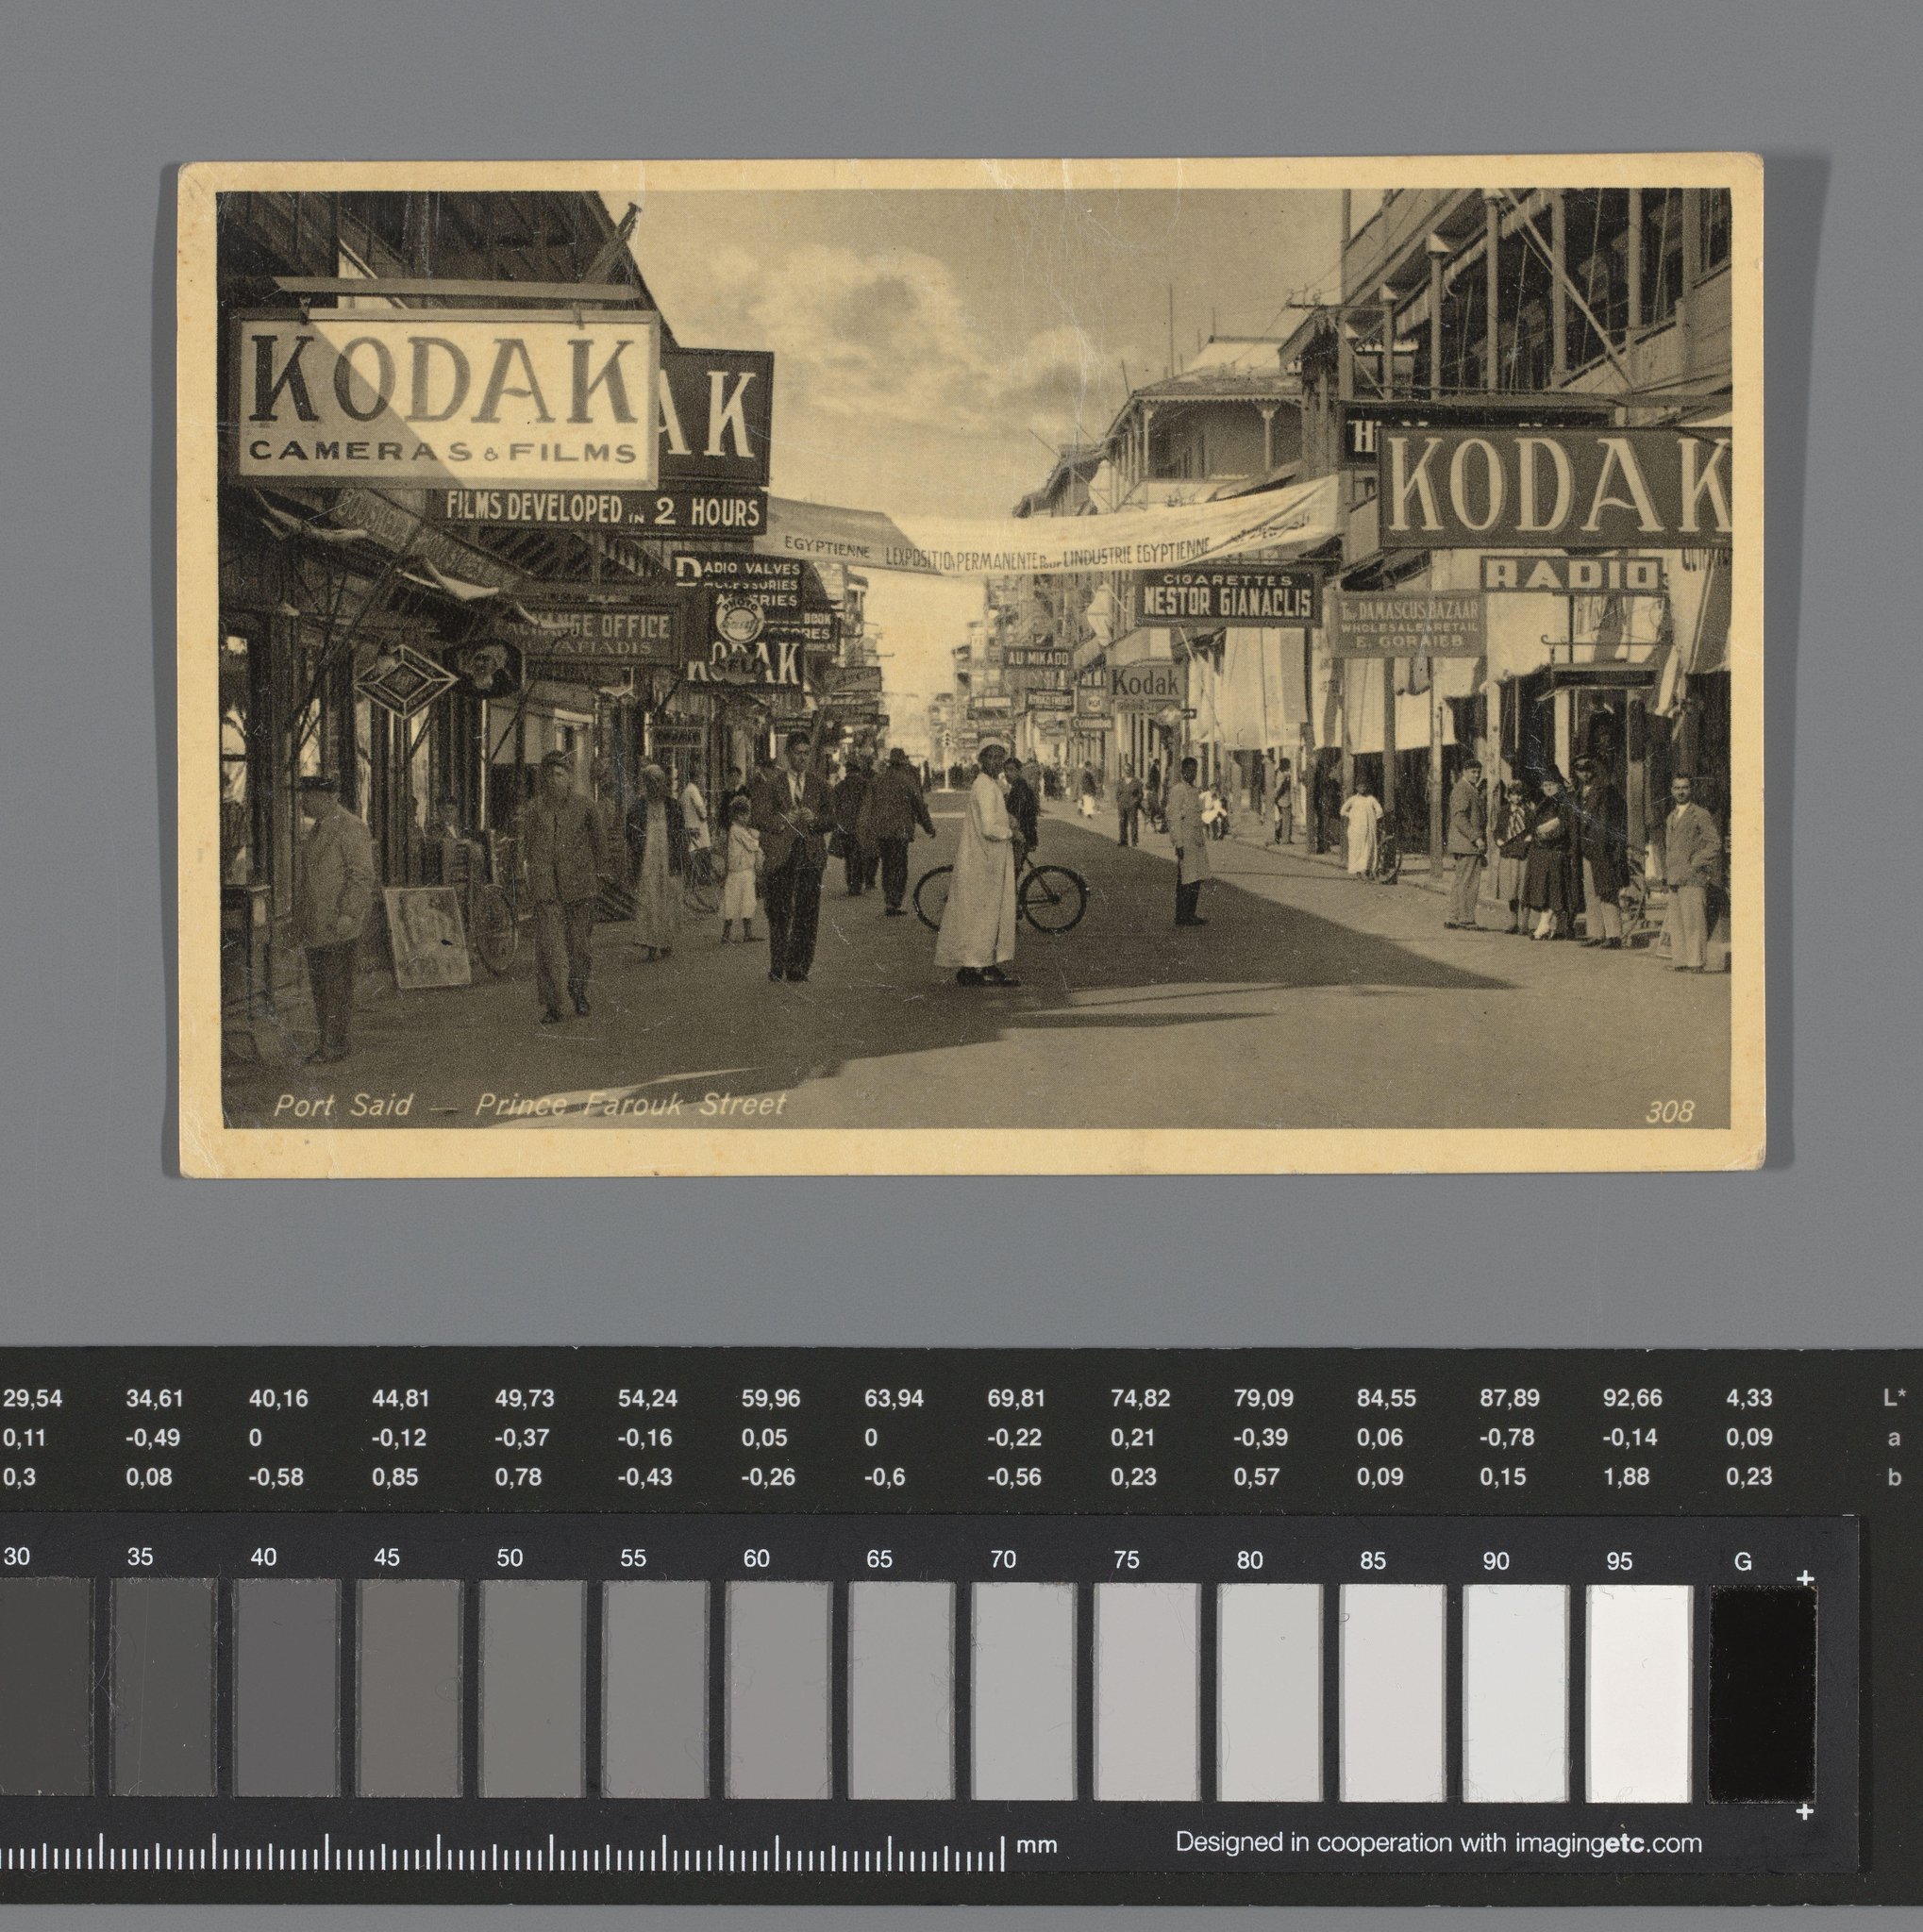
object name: photograph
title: The Oriental Commercial Bureau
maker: Anonymous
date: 1930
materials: paper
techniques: autotype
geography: port said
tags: manufacturer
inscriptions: inscription: ‘Port Said – Prince Farouk Street’, inscription: ‘PORT SAID / La Rue Prince Farouk / Die Prinz-Frauk-Straβe / Union Postale / POST CARD / Egypt / PUBL. & COPYRIGHT THE ORIENTAL COMMERCIAL / BUREAU PORT SAID (EGYPT)’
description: The Oriental Commercial Bureau (Port Said), Prins Faroukstraat in Port Said, Egypte, met links en rechts reclame voor Kodak.